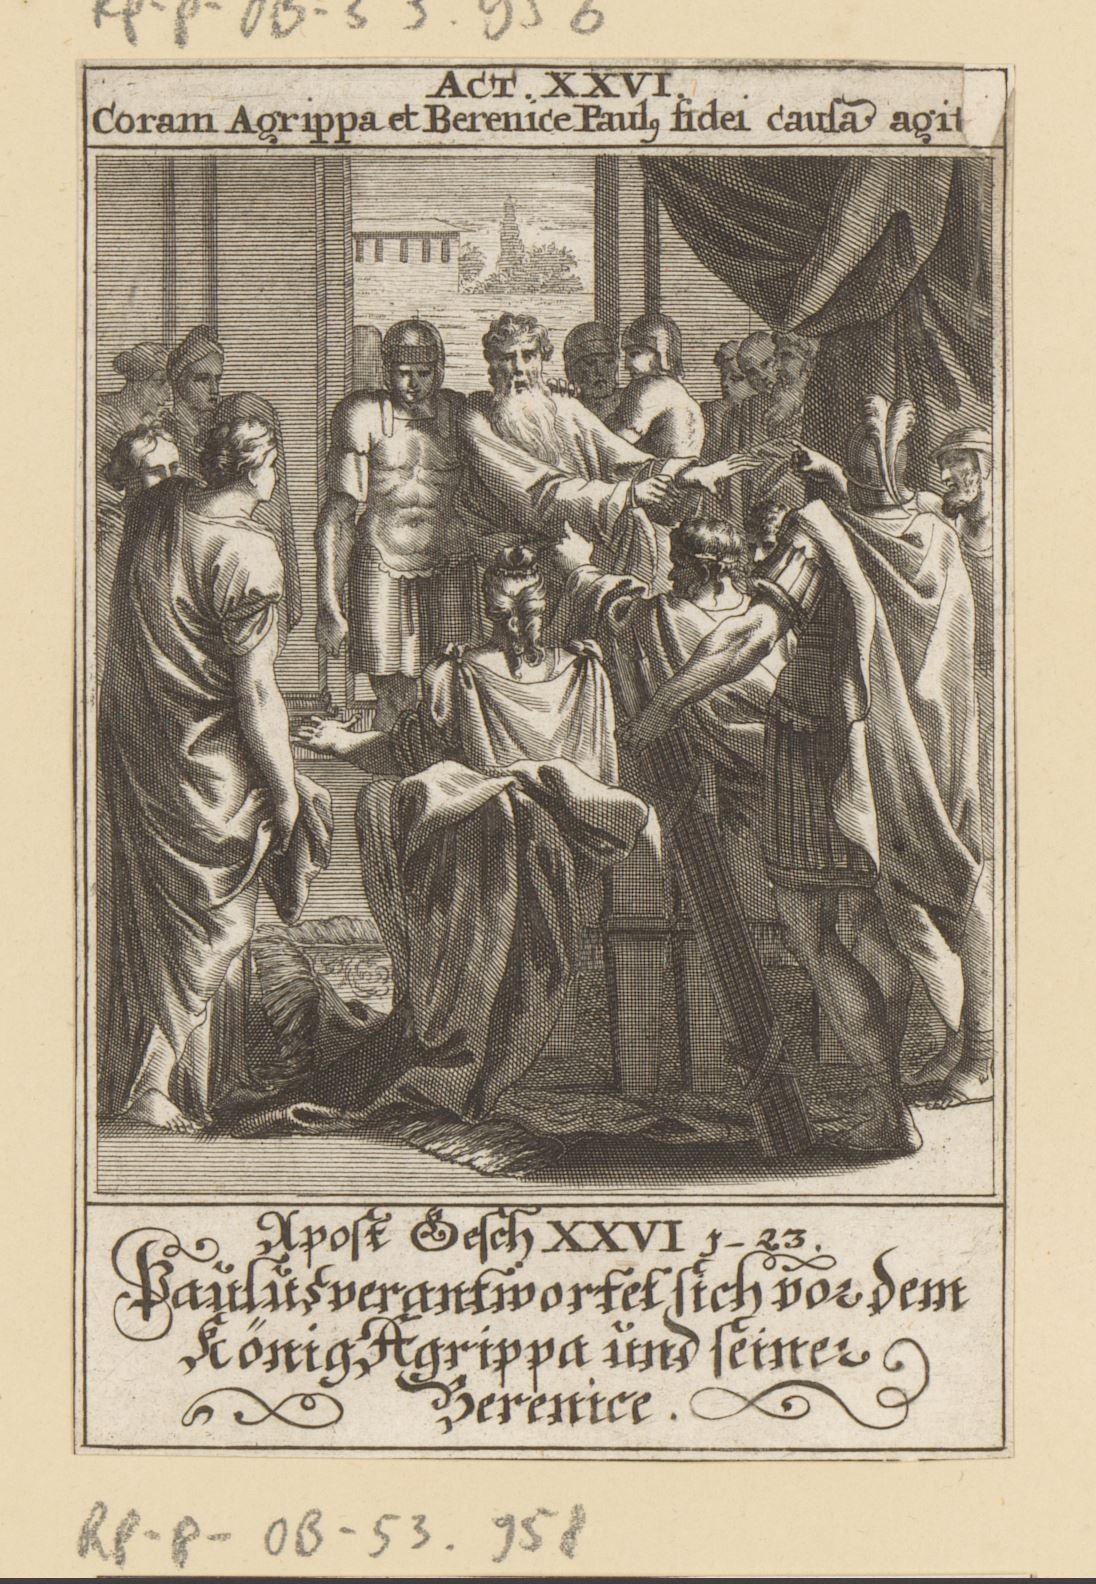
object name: print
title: Apostel Paulus verantwoordt zich voor koning Herodes Agrippa II en Julia Berenice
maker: Anonymous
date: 1697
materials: paper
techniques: etching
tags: paul before festus, king agrippa and queen bernice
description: Prent ook gebruikt in: Biblia ectypa : Bildnussen auss Heiliger Schrifft. Regensburg: Chr. Wiegel, 1697.